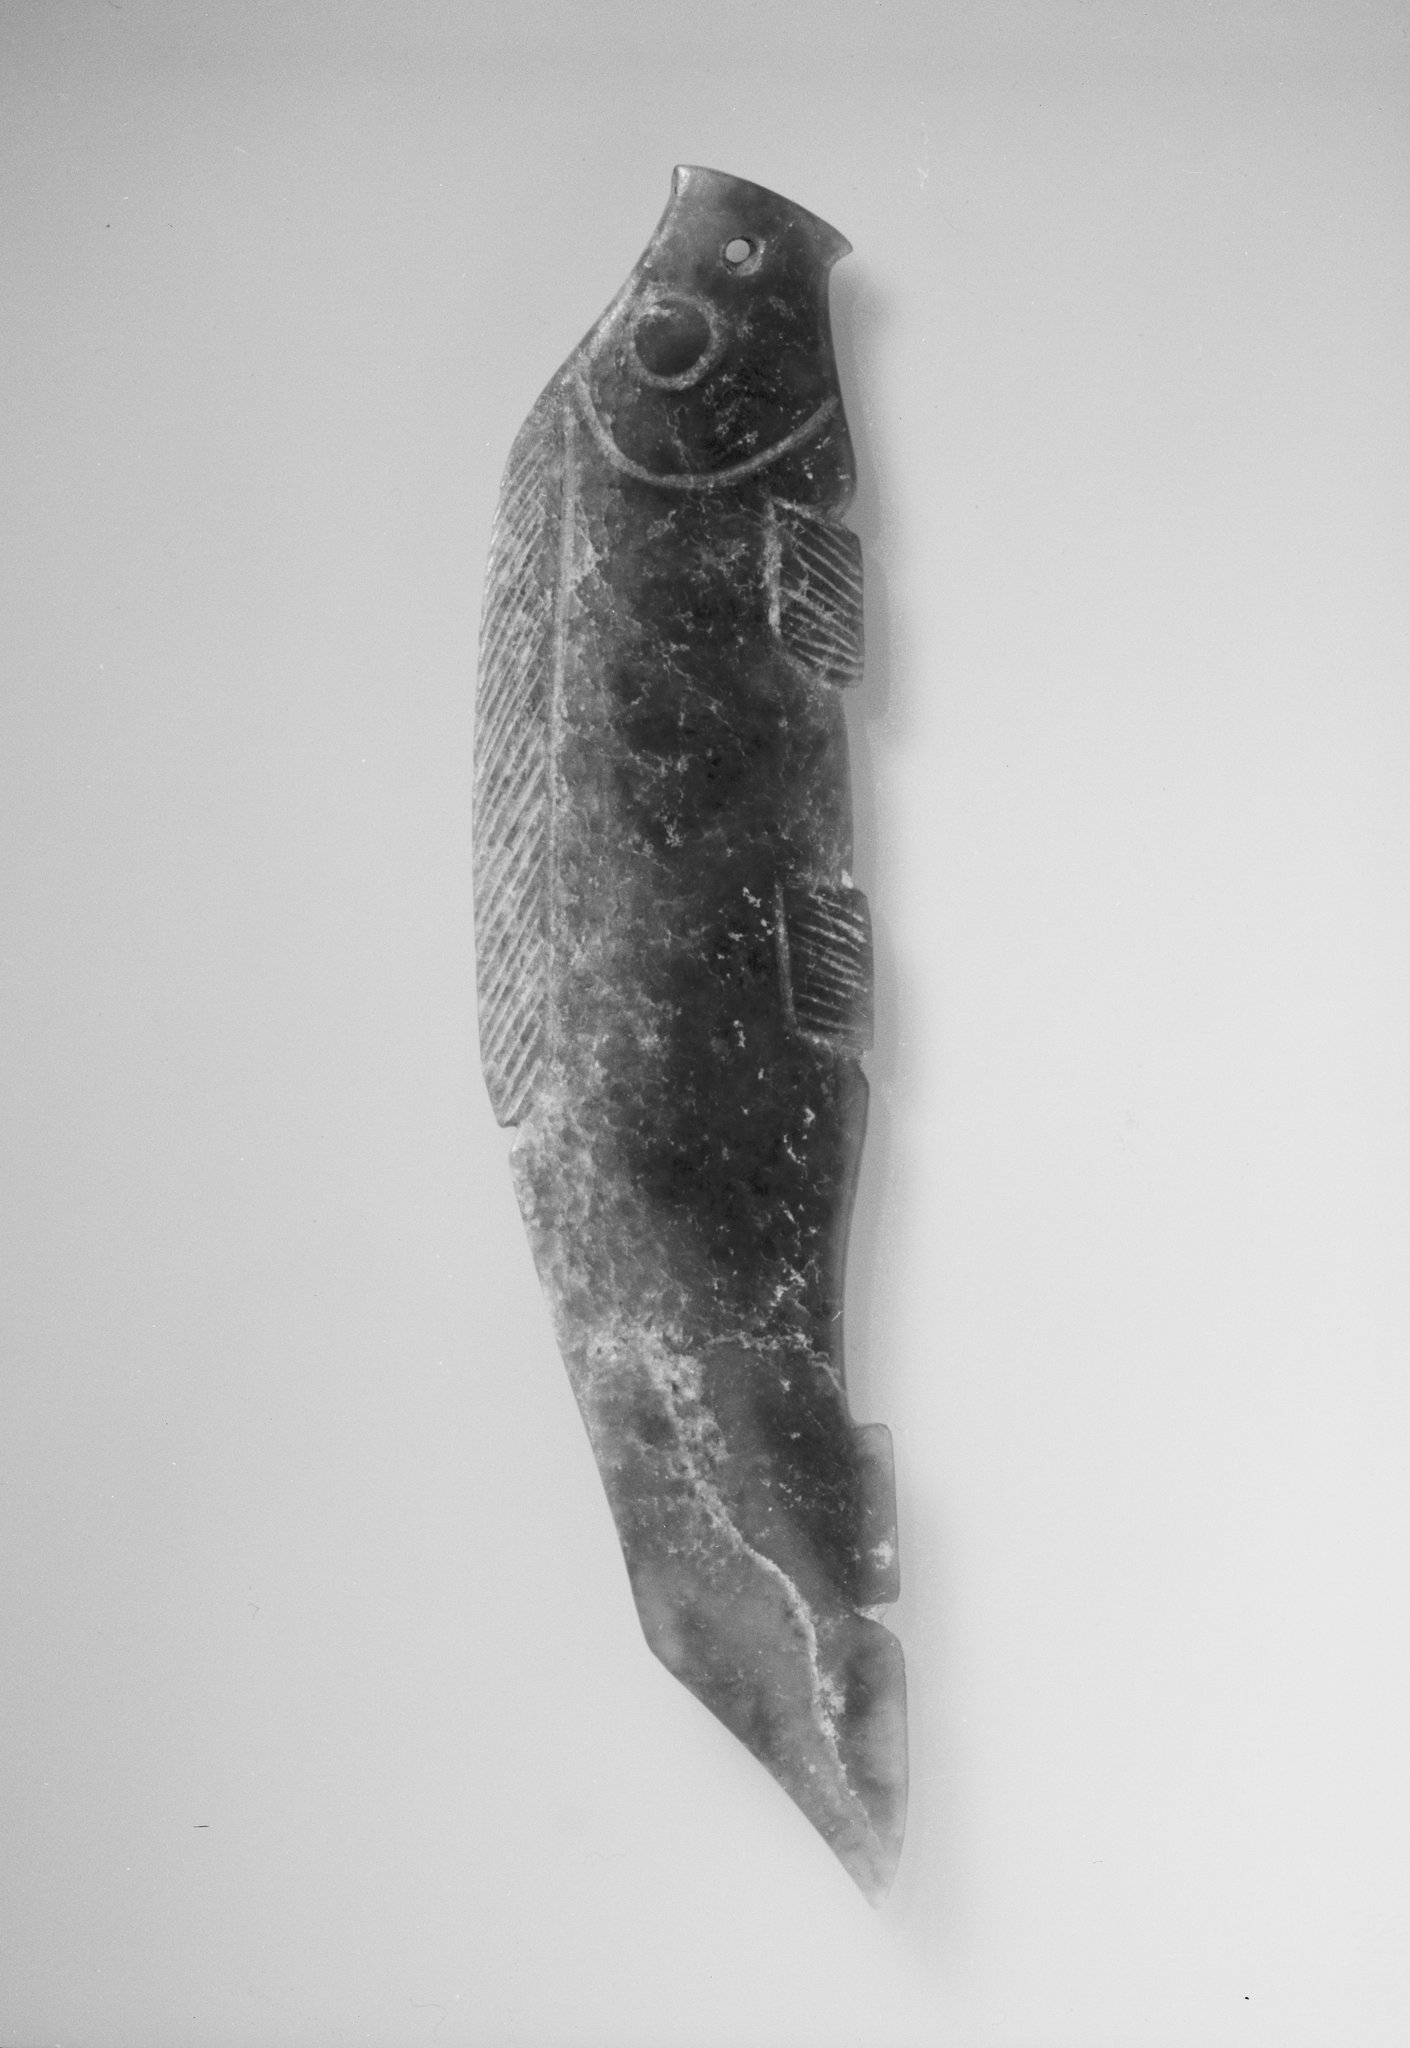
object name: plaque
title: Plaque in the shape of a fish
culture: chinese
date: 1600-771 BCE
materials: jade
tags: fish